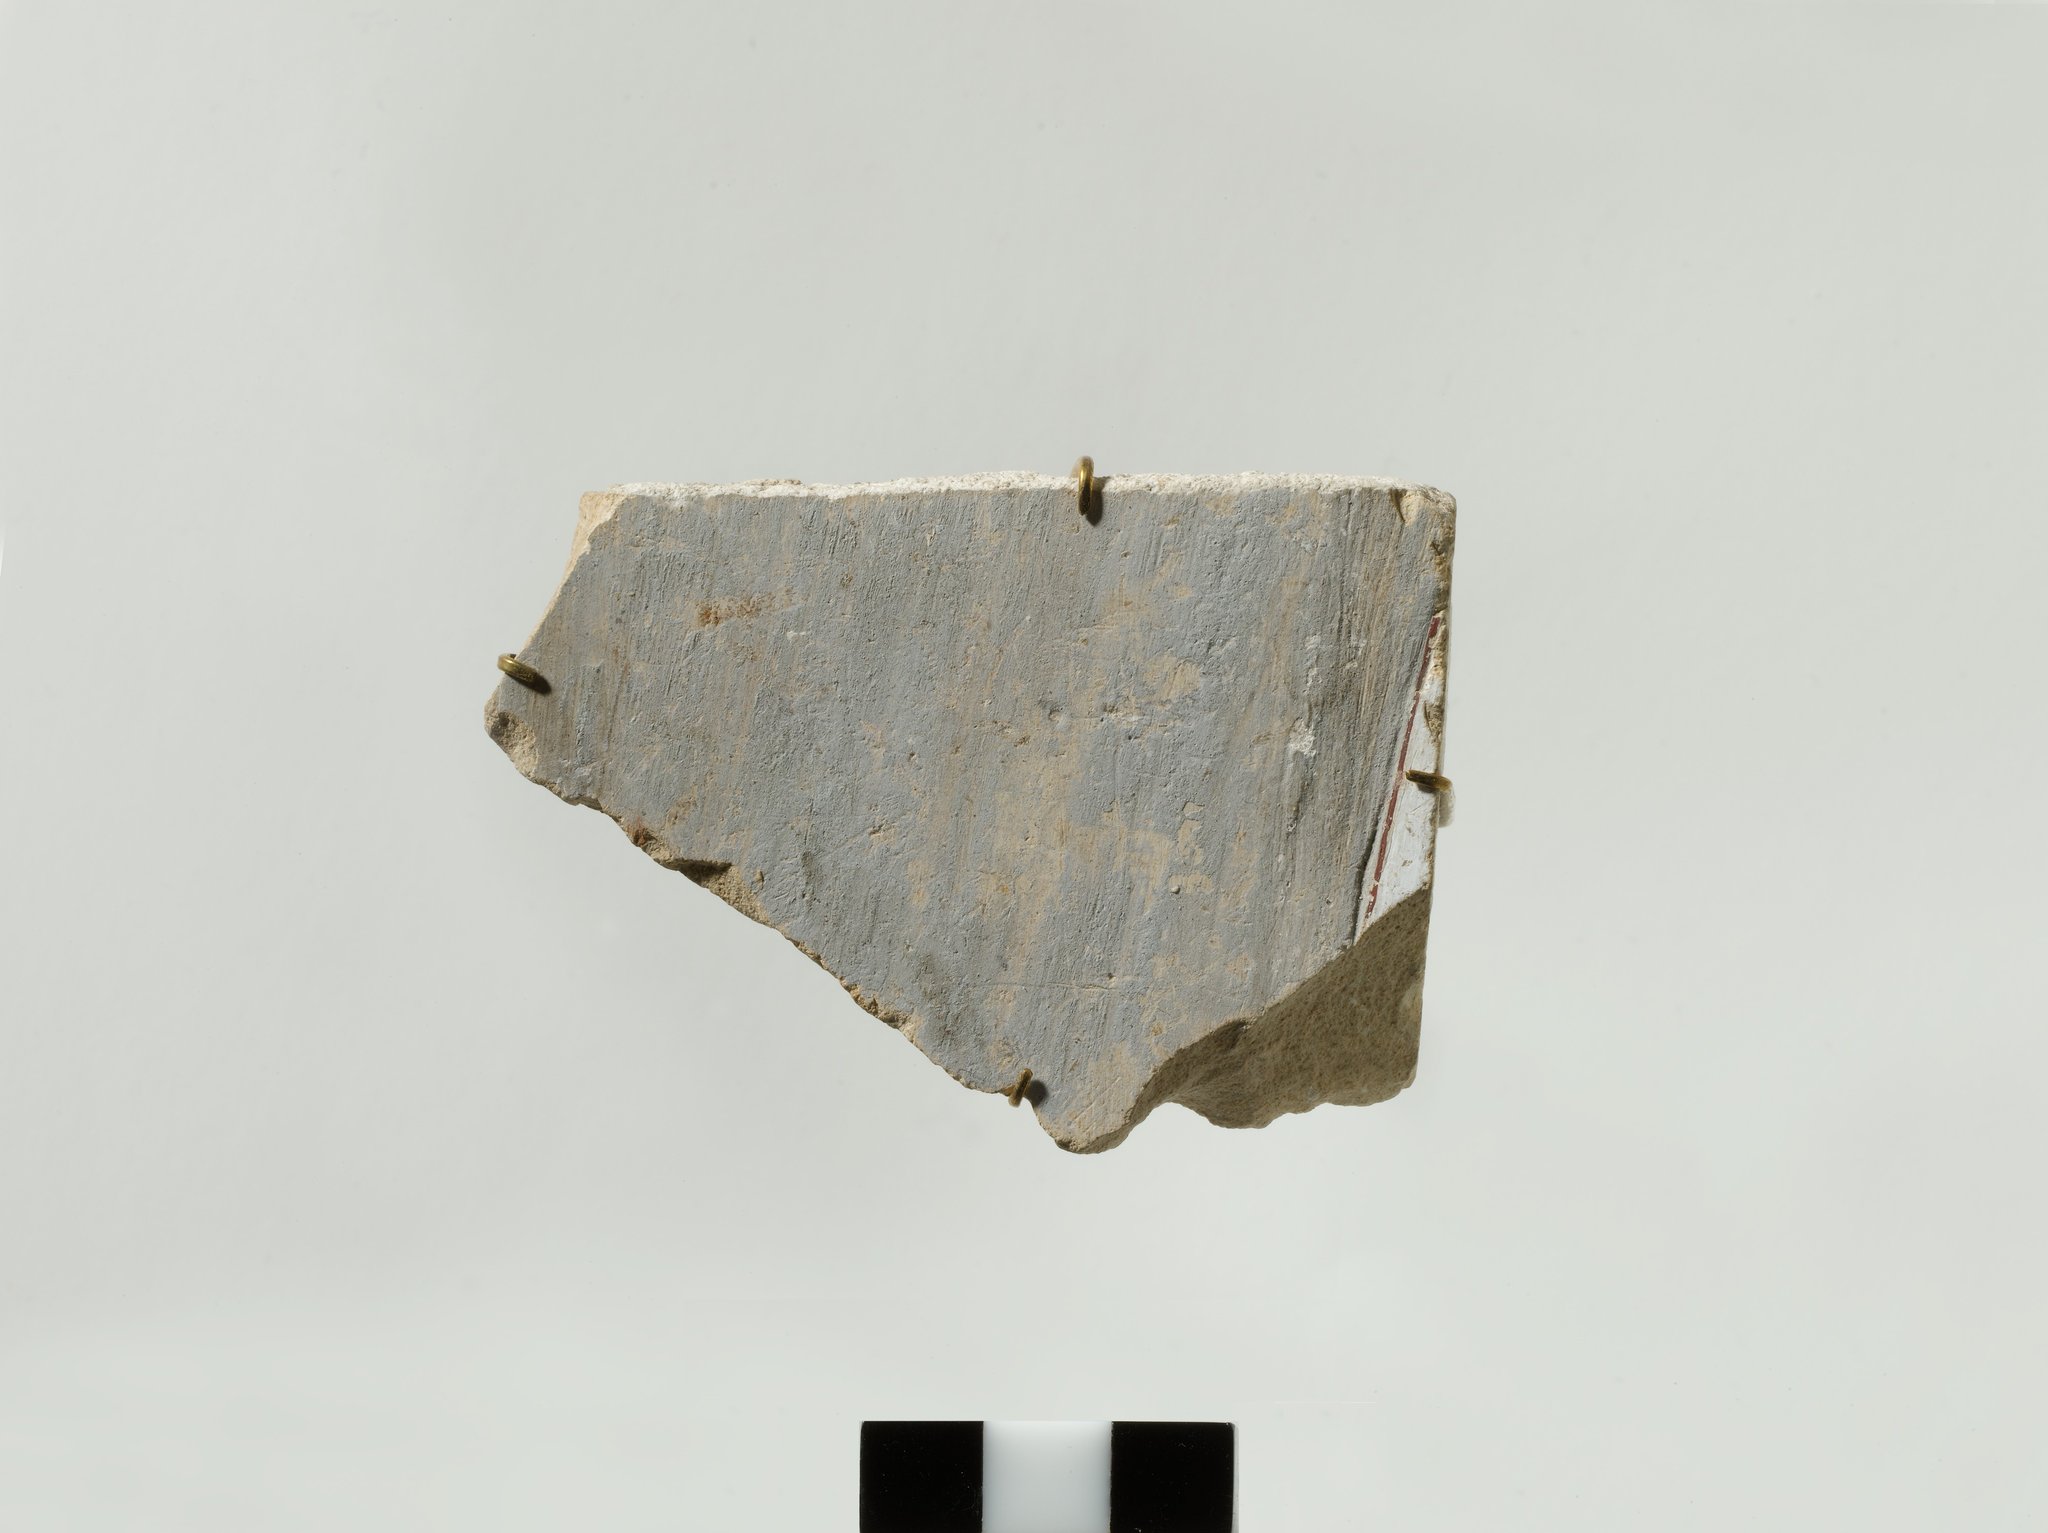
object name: relief fragment, tomb of meketre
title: Relief fragment from the tomb of Meketre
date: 1981-1975 BCE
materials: limestone, paint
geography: egypt